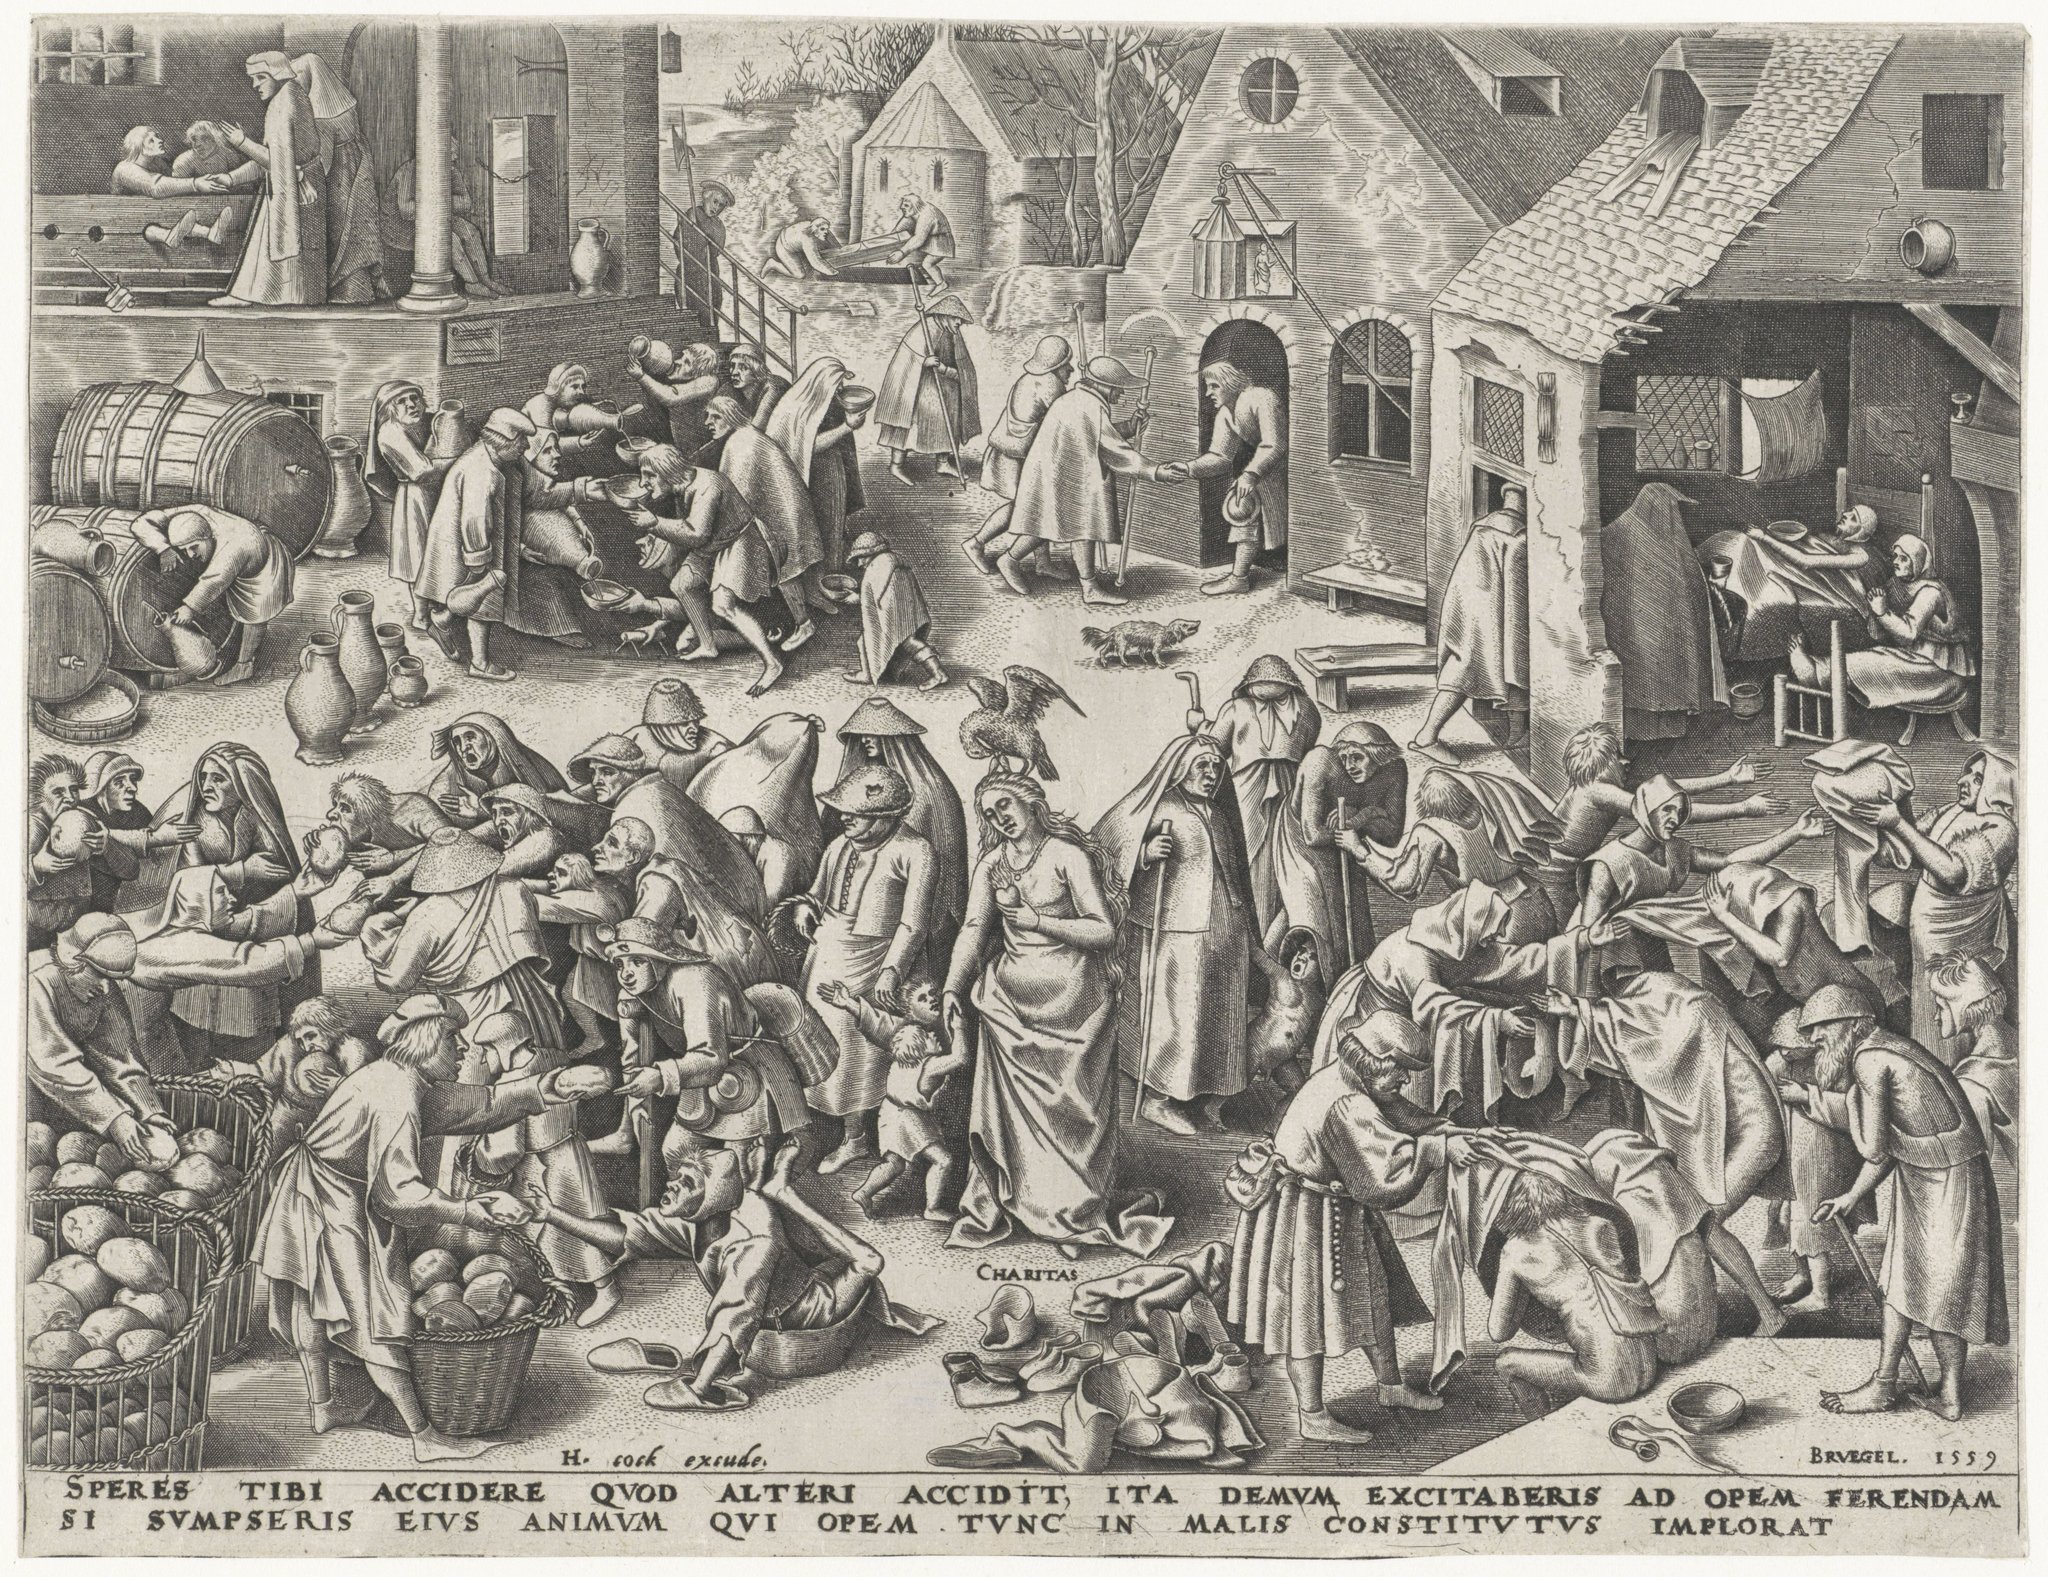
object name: print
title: De zeven deugden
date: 1559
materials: paper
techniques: engraving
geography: antwerp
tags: charity, 'caritas'; 'carità' (ripa) ~ one of the three theological virtues, the (seven) acts of mercy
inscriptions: collector's mark: Lugt 2228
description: De vrouwelijke personificatie van Liefde (Caritas) staat met twee kleine kinderen aan de hand ten midden van de werken van barmhartigheid. Rond haar worden de hongerigen gevoed, krijgen de dorstigen te drinken, worden de naakten gekleed, worden de gevangenen bezocht, worden de gasten ontvangen, worden de zieken verzorgd en worden de doden begraven. Onder de voorstelling een tweeregelige tekst in het Latijn.